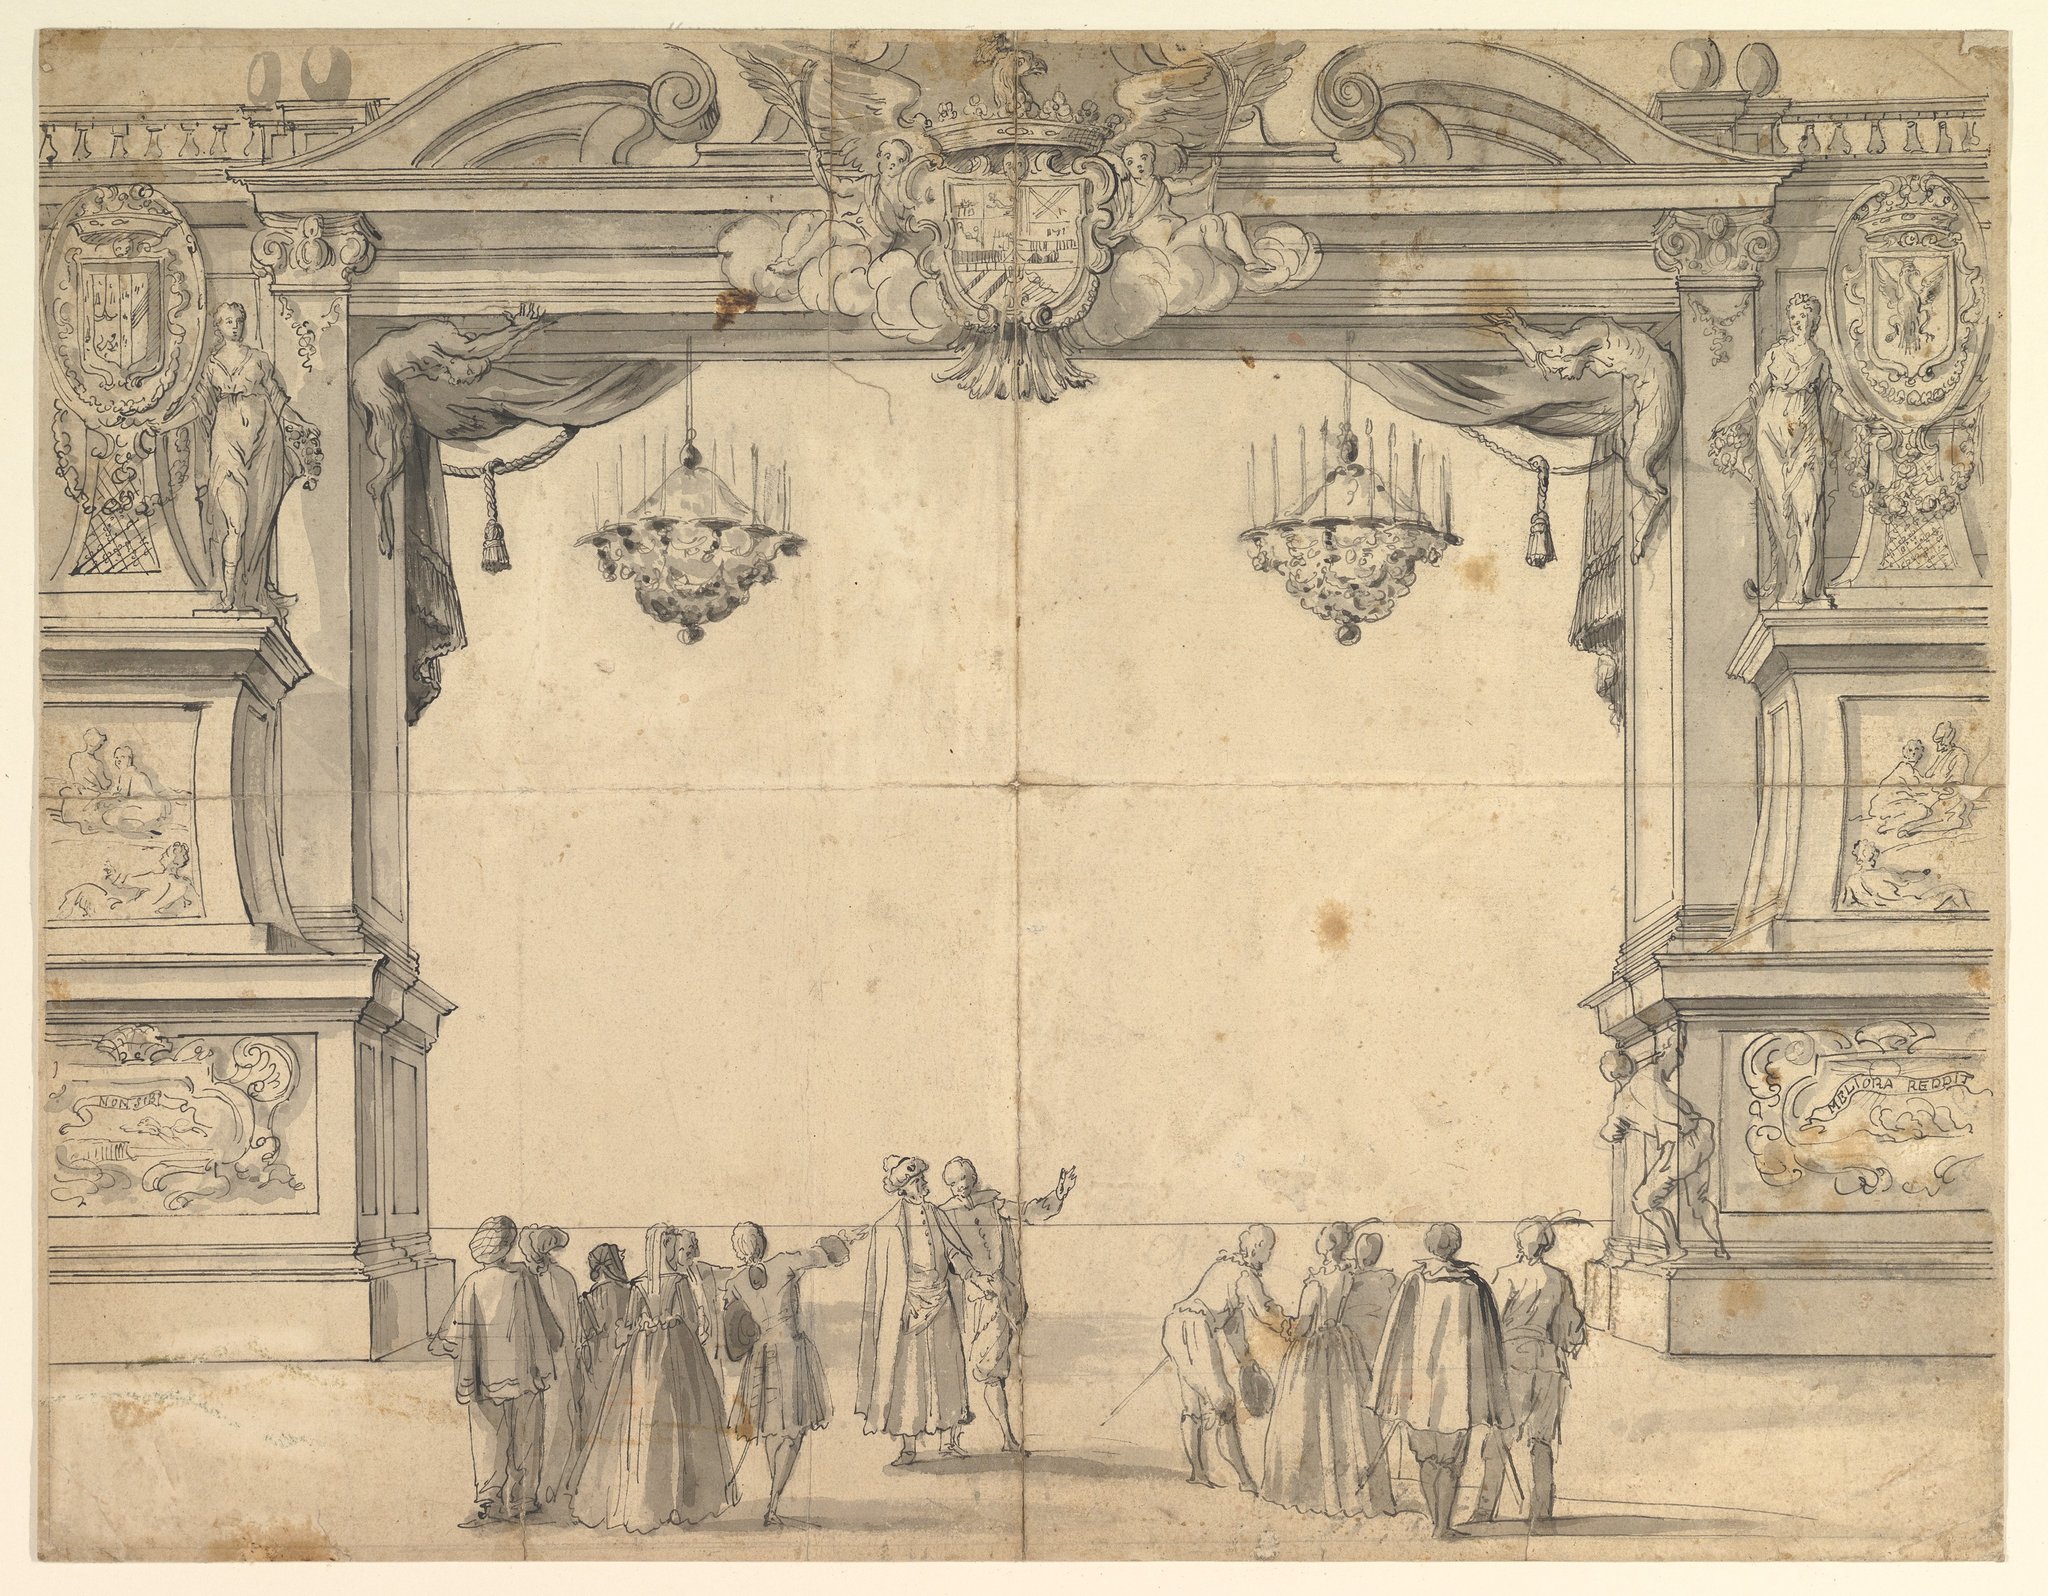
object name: drawing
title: Proscenium Arch of a Court Theater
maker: anonymous, italian, 18th century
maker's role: artist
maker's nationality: italian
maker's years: 1700-1800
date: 1701-1800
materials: ink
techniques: brush, pen, wash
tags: birds,sculpture,men,women,coat of arms